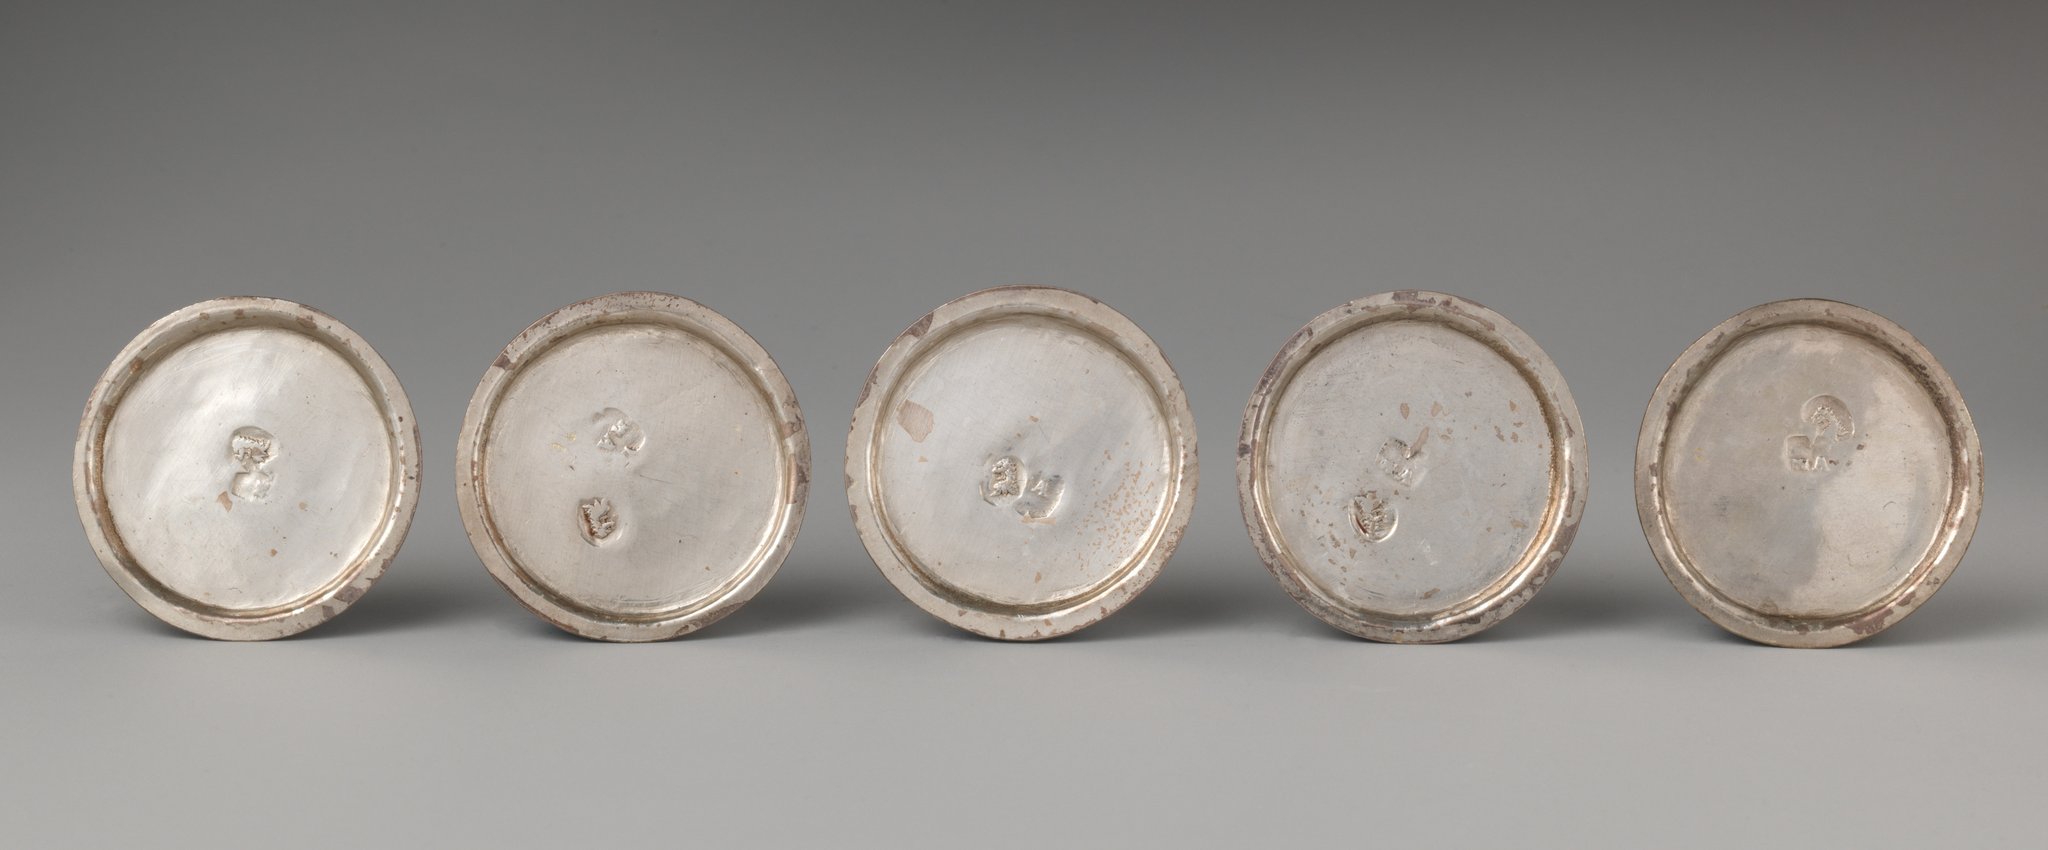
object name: dish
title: Five miniature dishes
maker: george manjoy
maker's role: maker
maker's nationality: british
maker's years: 1685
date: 1701-1800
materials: silver